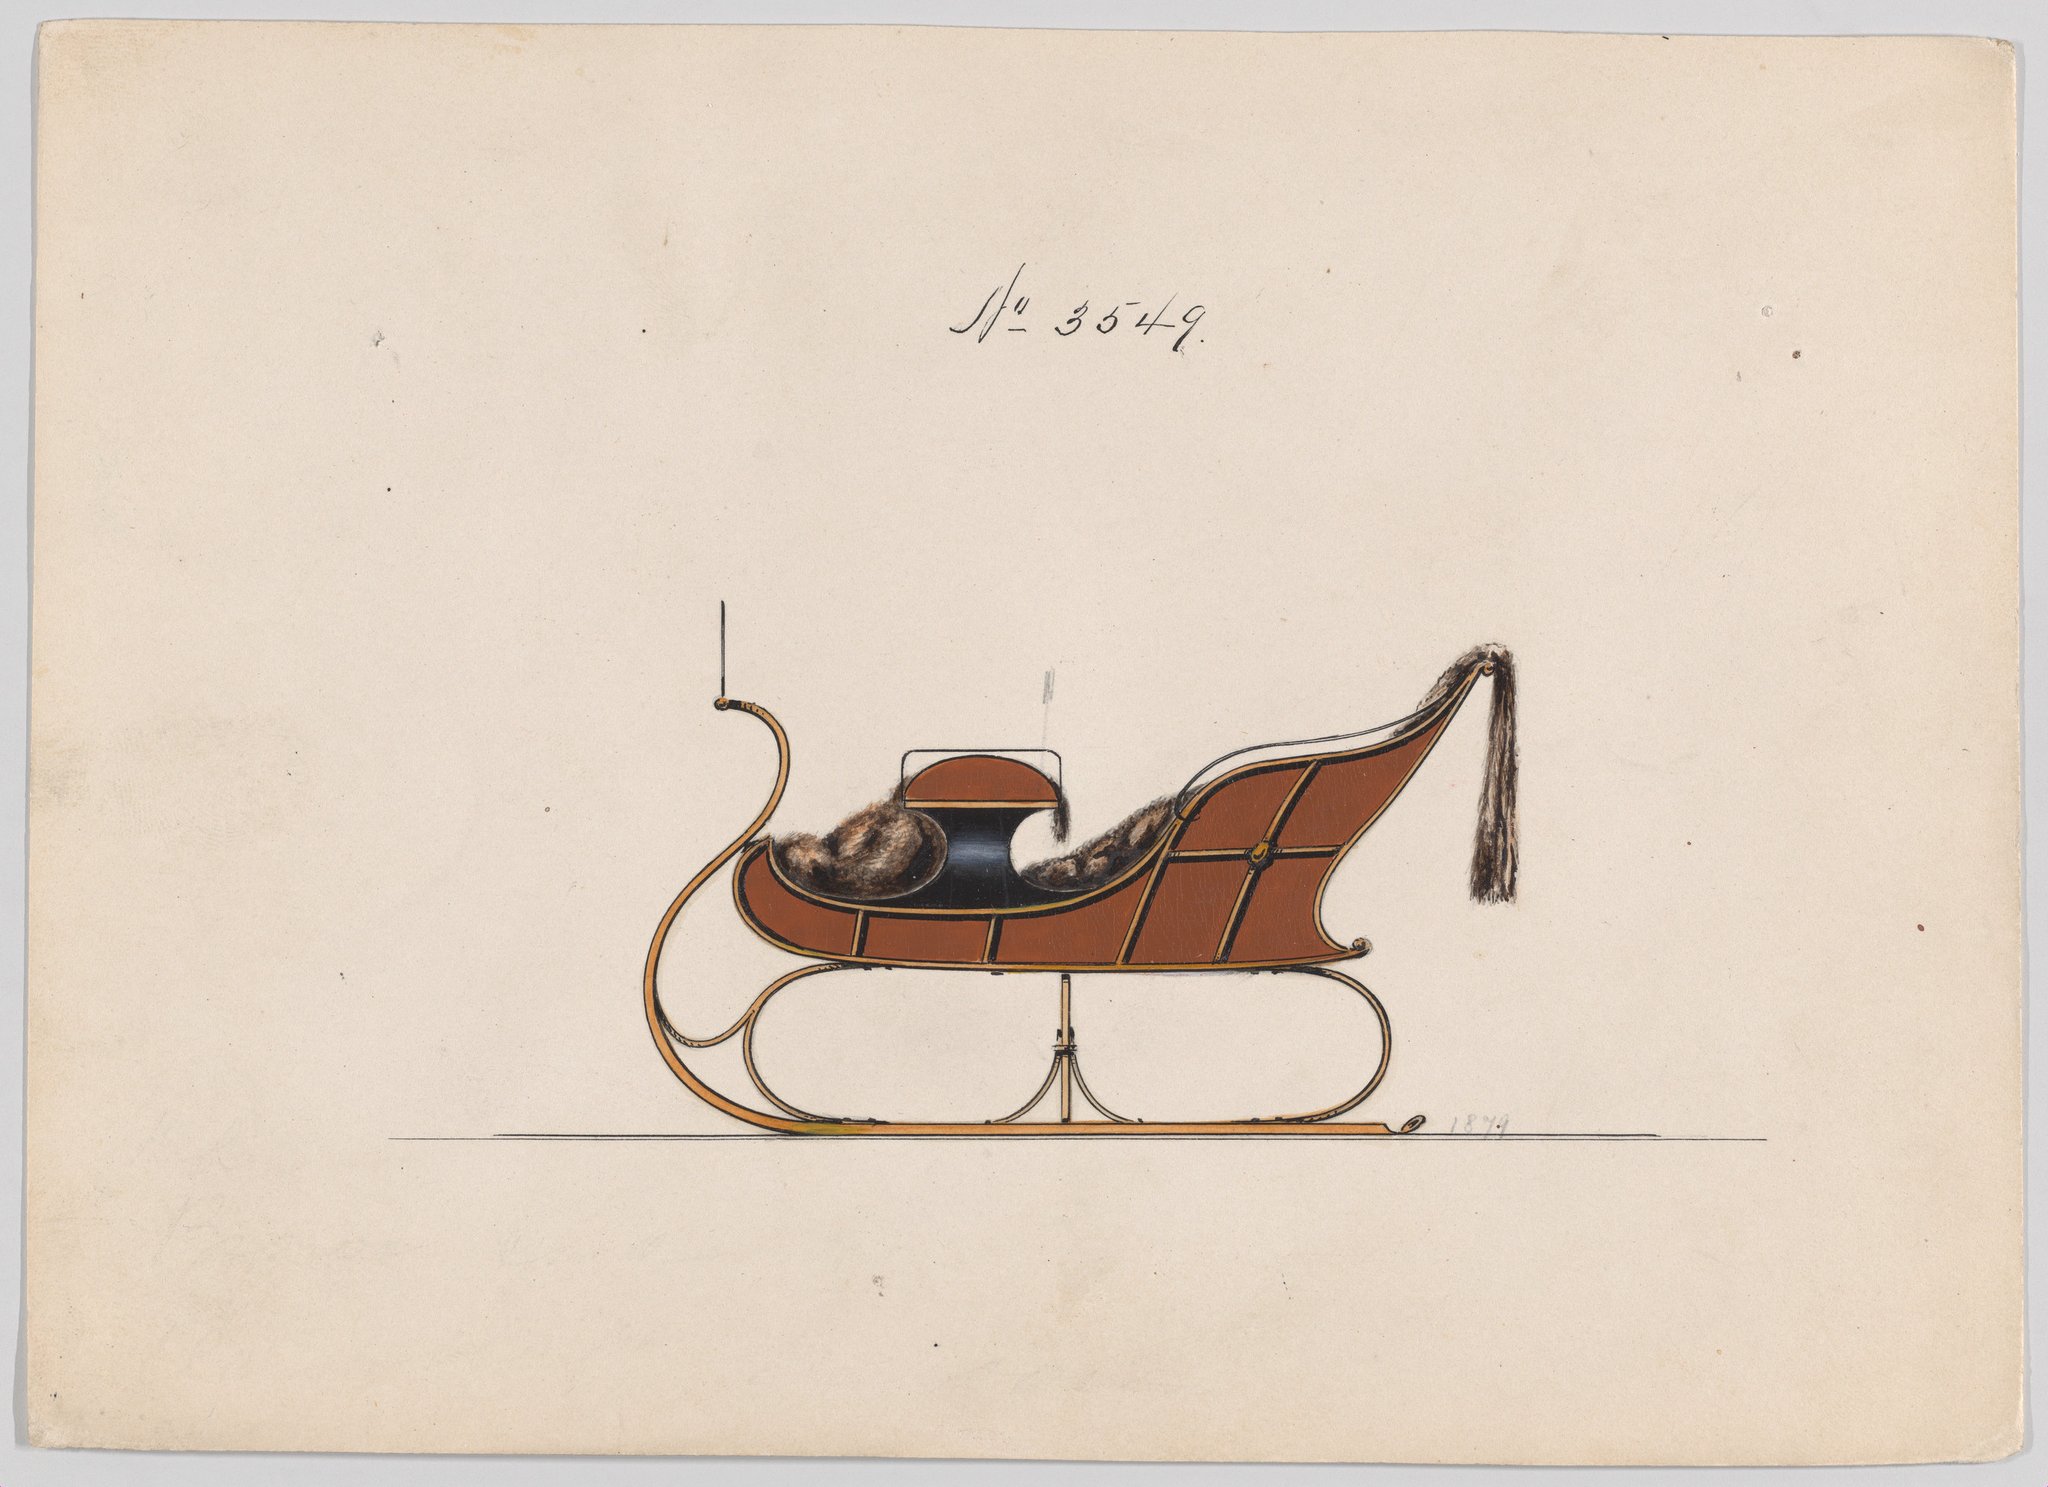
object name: drawing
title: Design for 4 Seat Sleigh, no. 3549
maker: brewster & co.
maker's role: manufacturer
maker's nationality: american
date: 1879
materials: gouache, gum arabic, ink, watercolor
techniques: pen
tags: sleighs